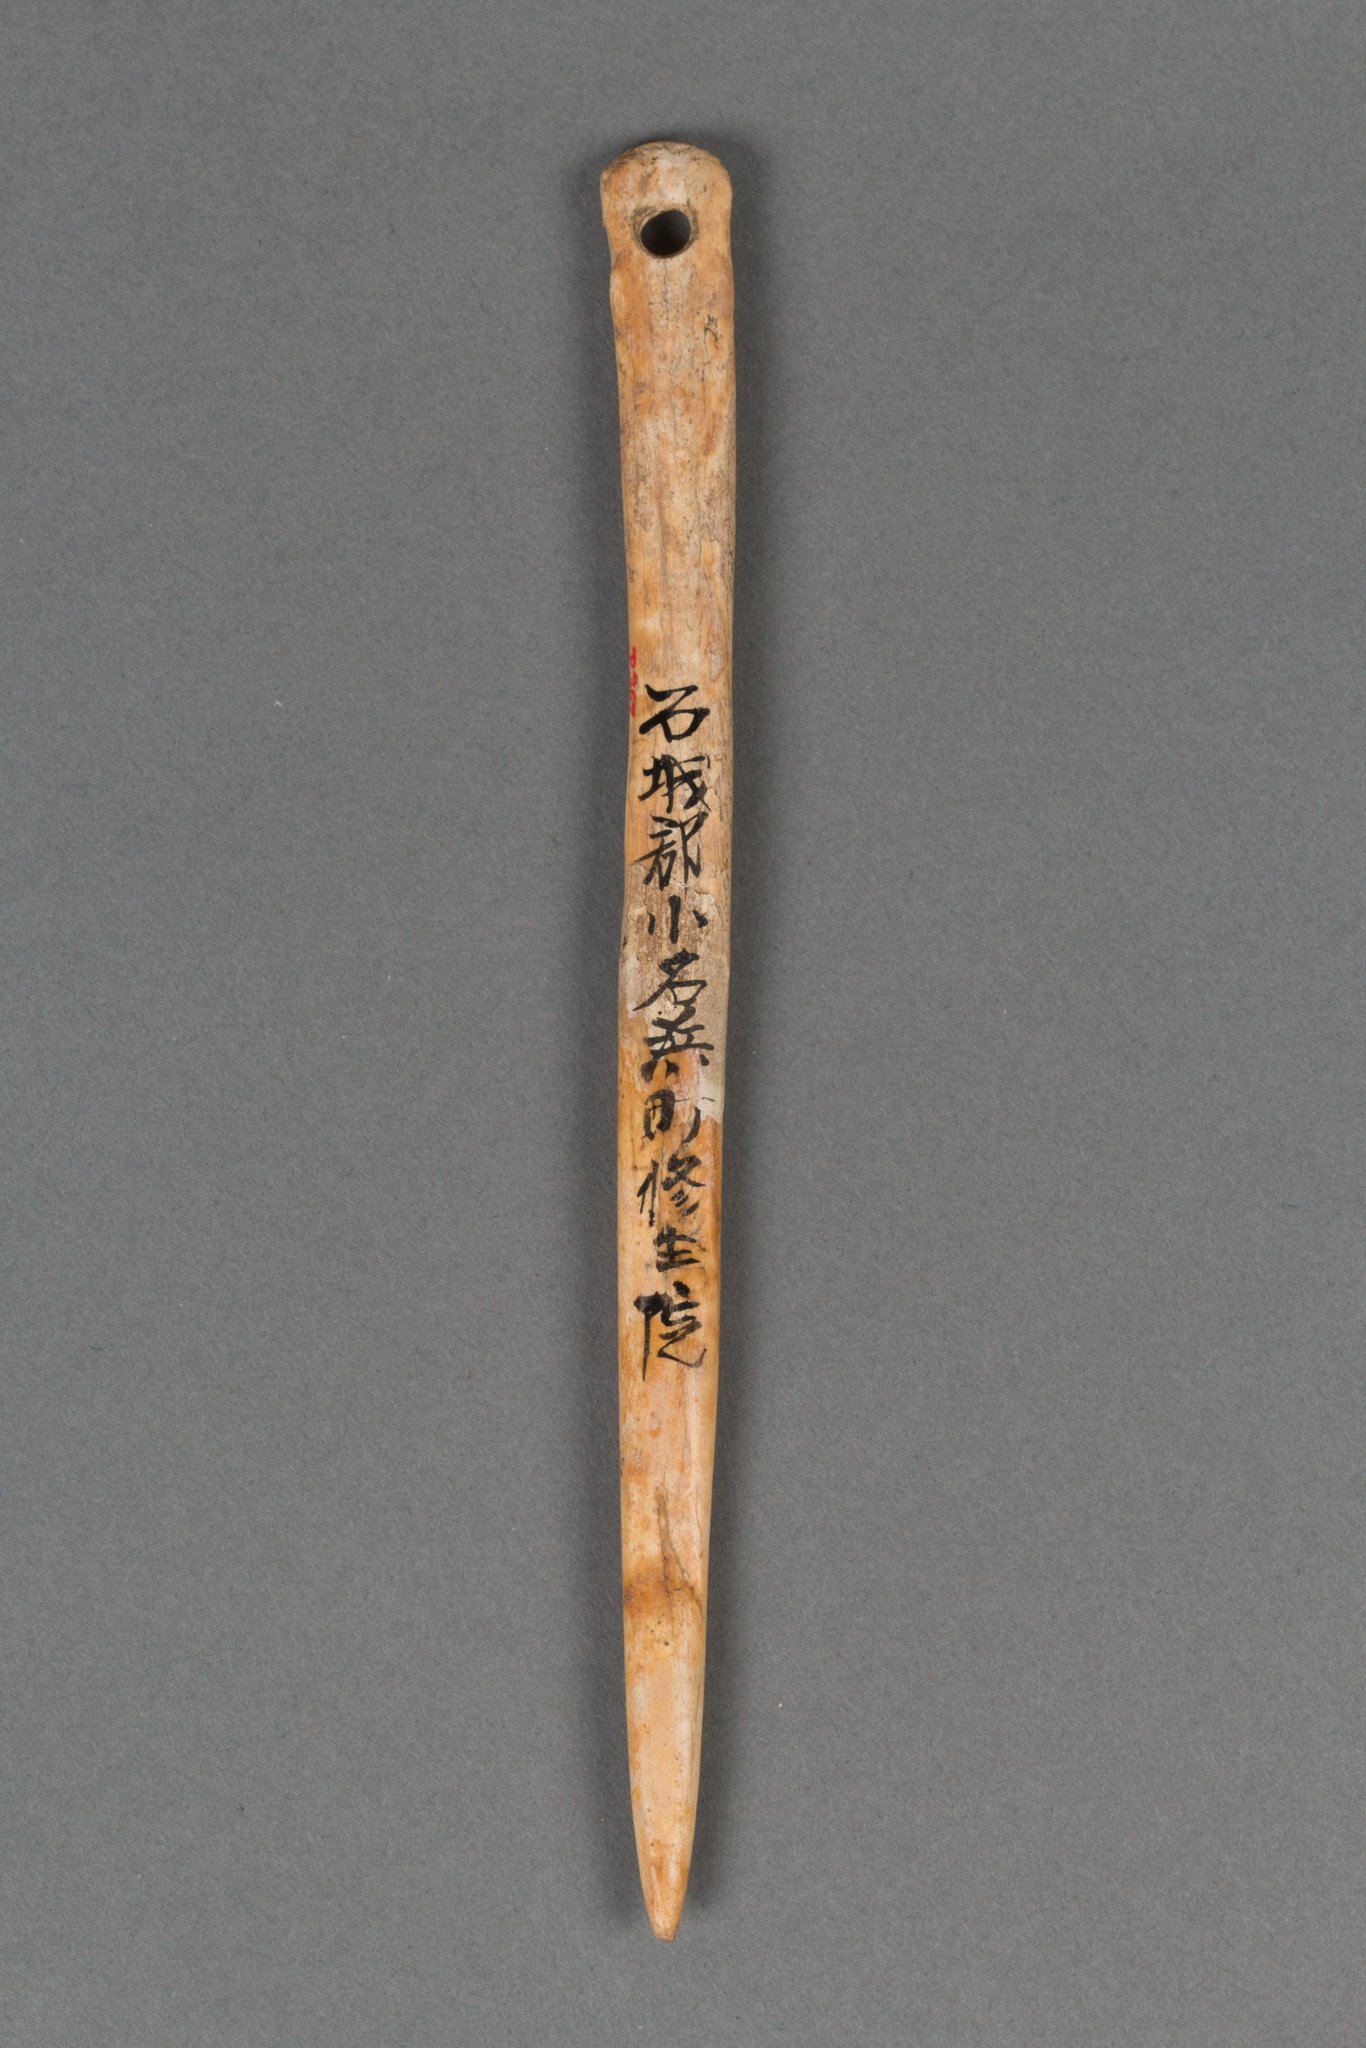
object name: needle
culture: japanese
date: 1200-200 BCE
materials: bone